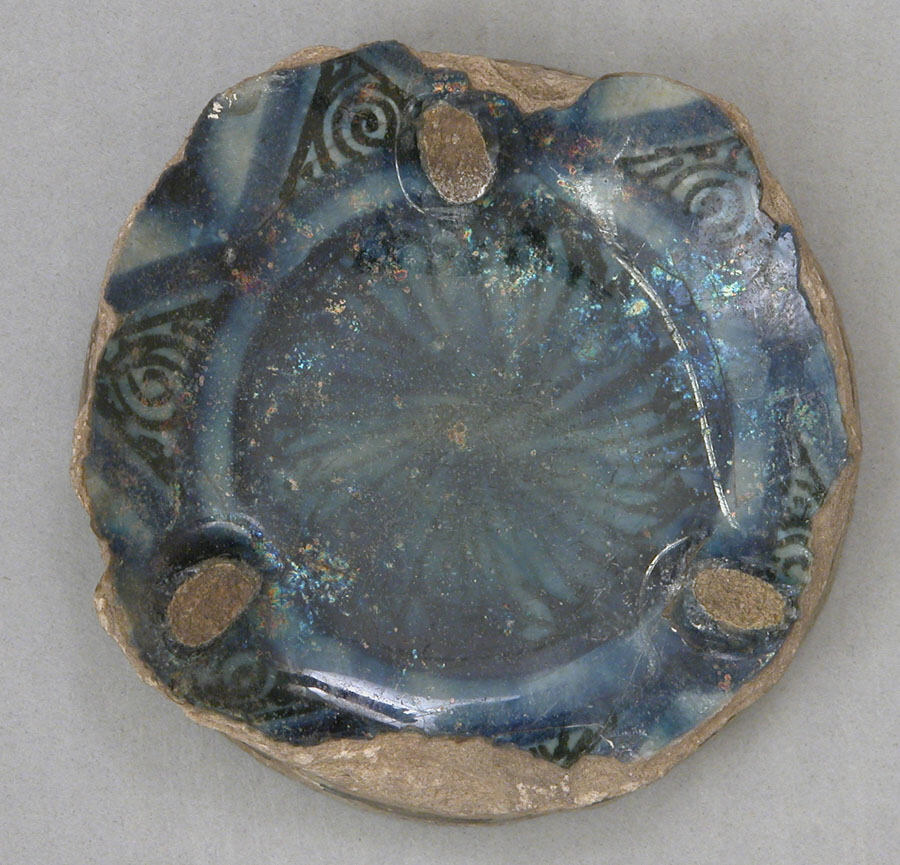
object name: fragment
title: Fragment of a Bowl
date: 1301-1500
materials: stonepaste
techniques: painting, polychrome, underglaze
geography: egypt